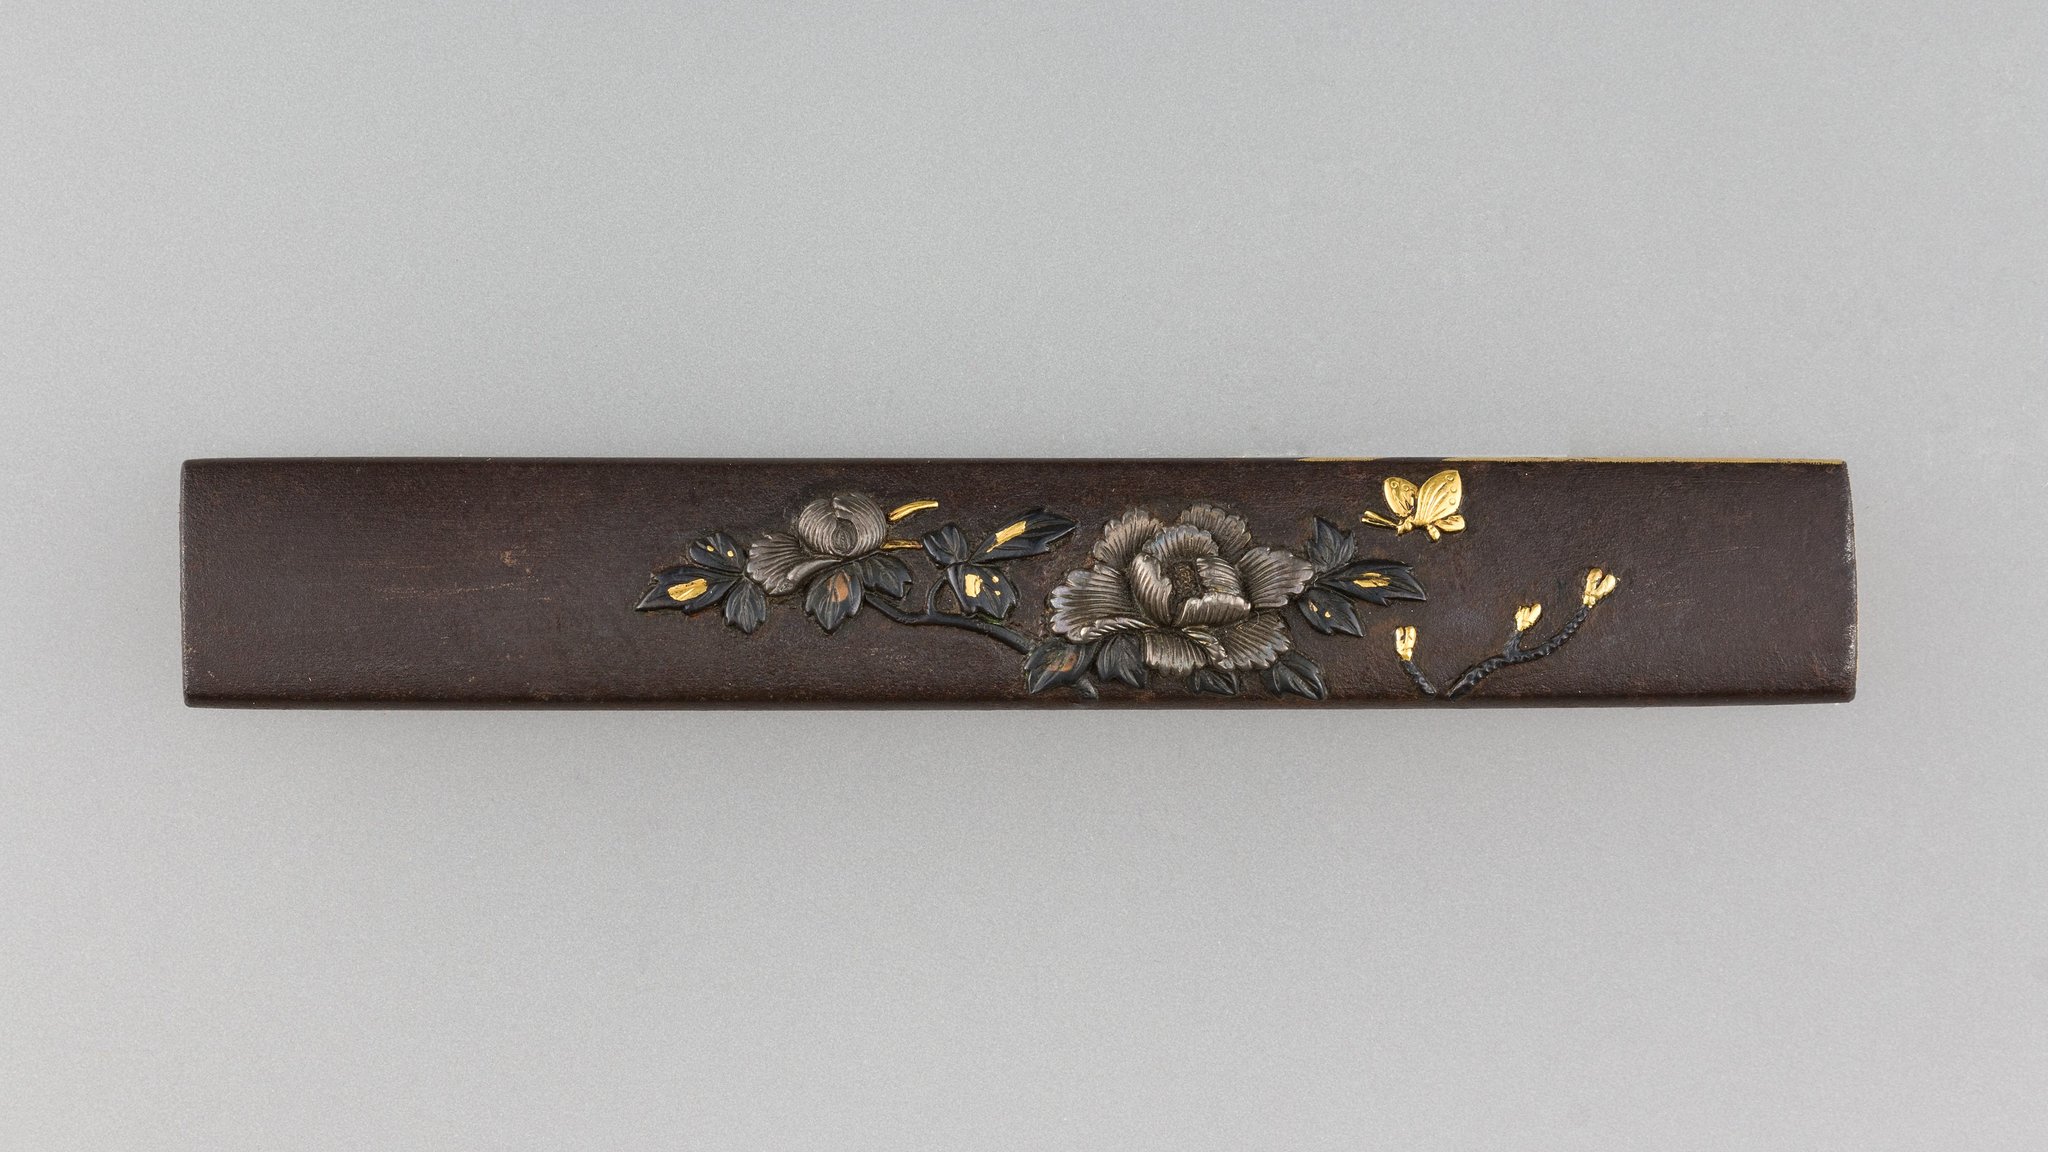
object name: knife handle kozuka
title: Knife Handle (Kozuka)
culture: japanese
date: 1767-1800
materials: gold alloy, gold, iron, silver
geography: japan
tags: flowers